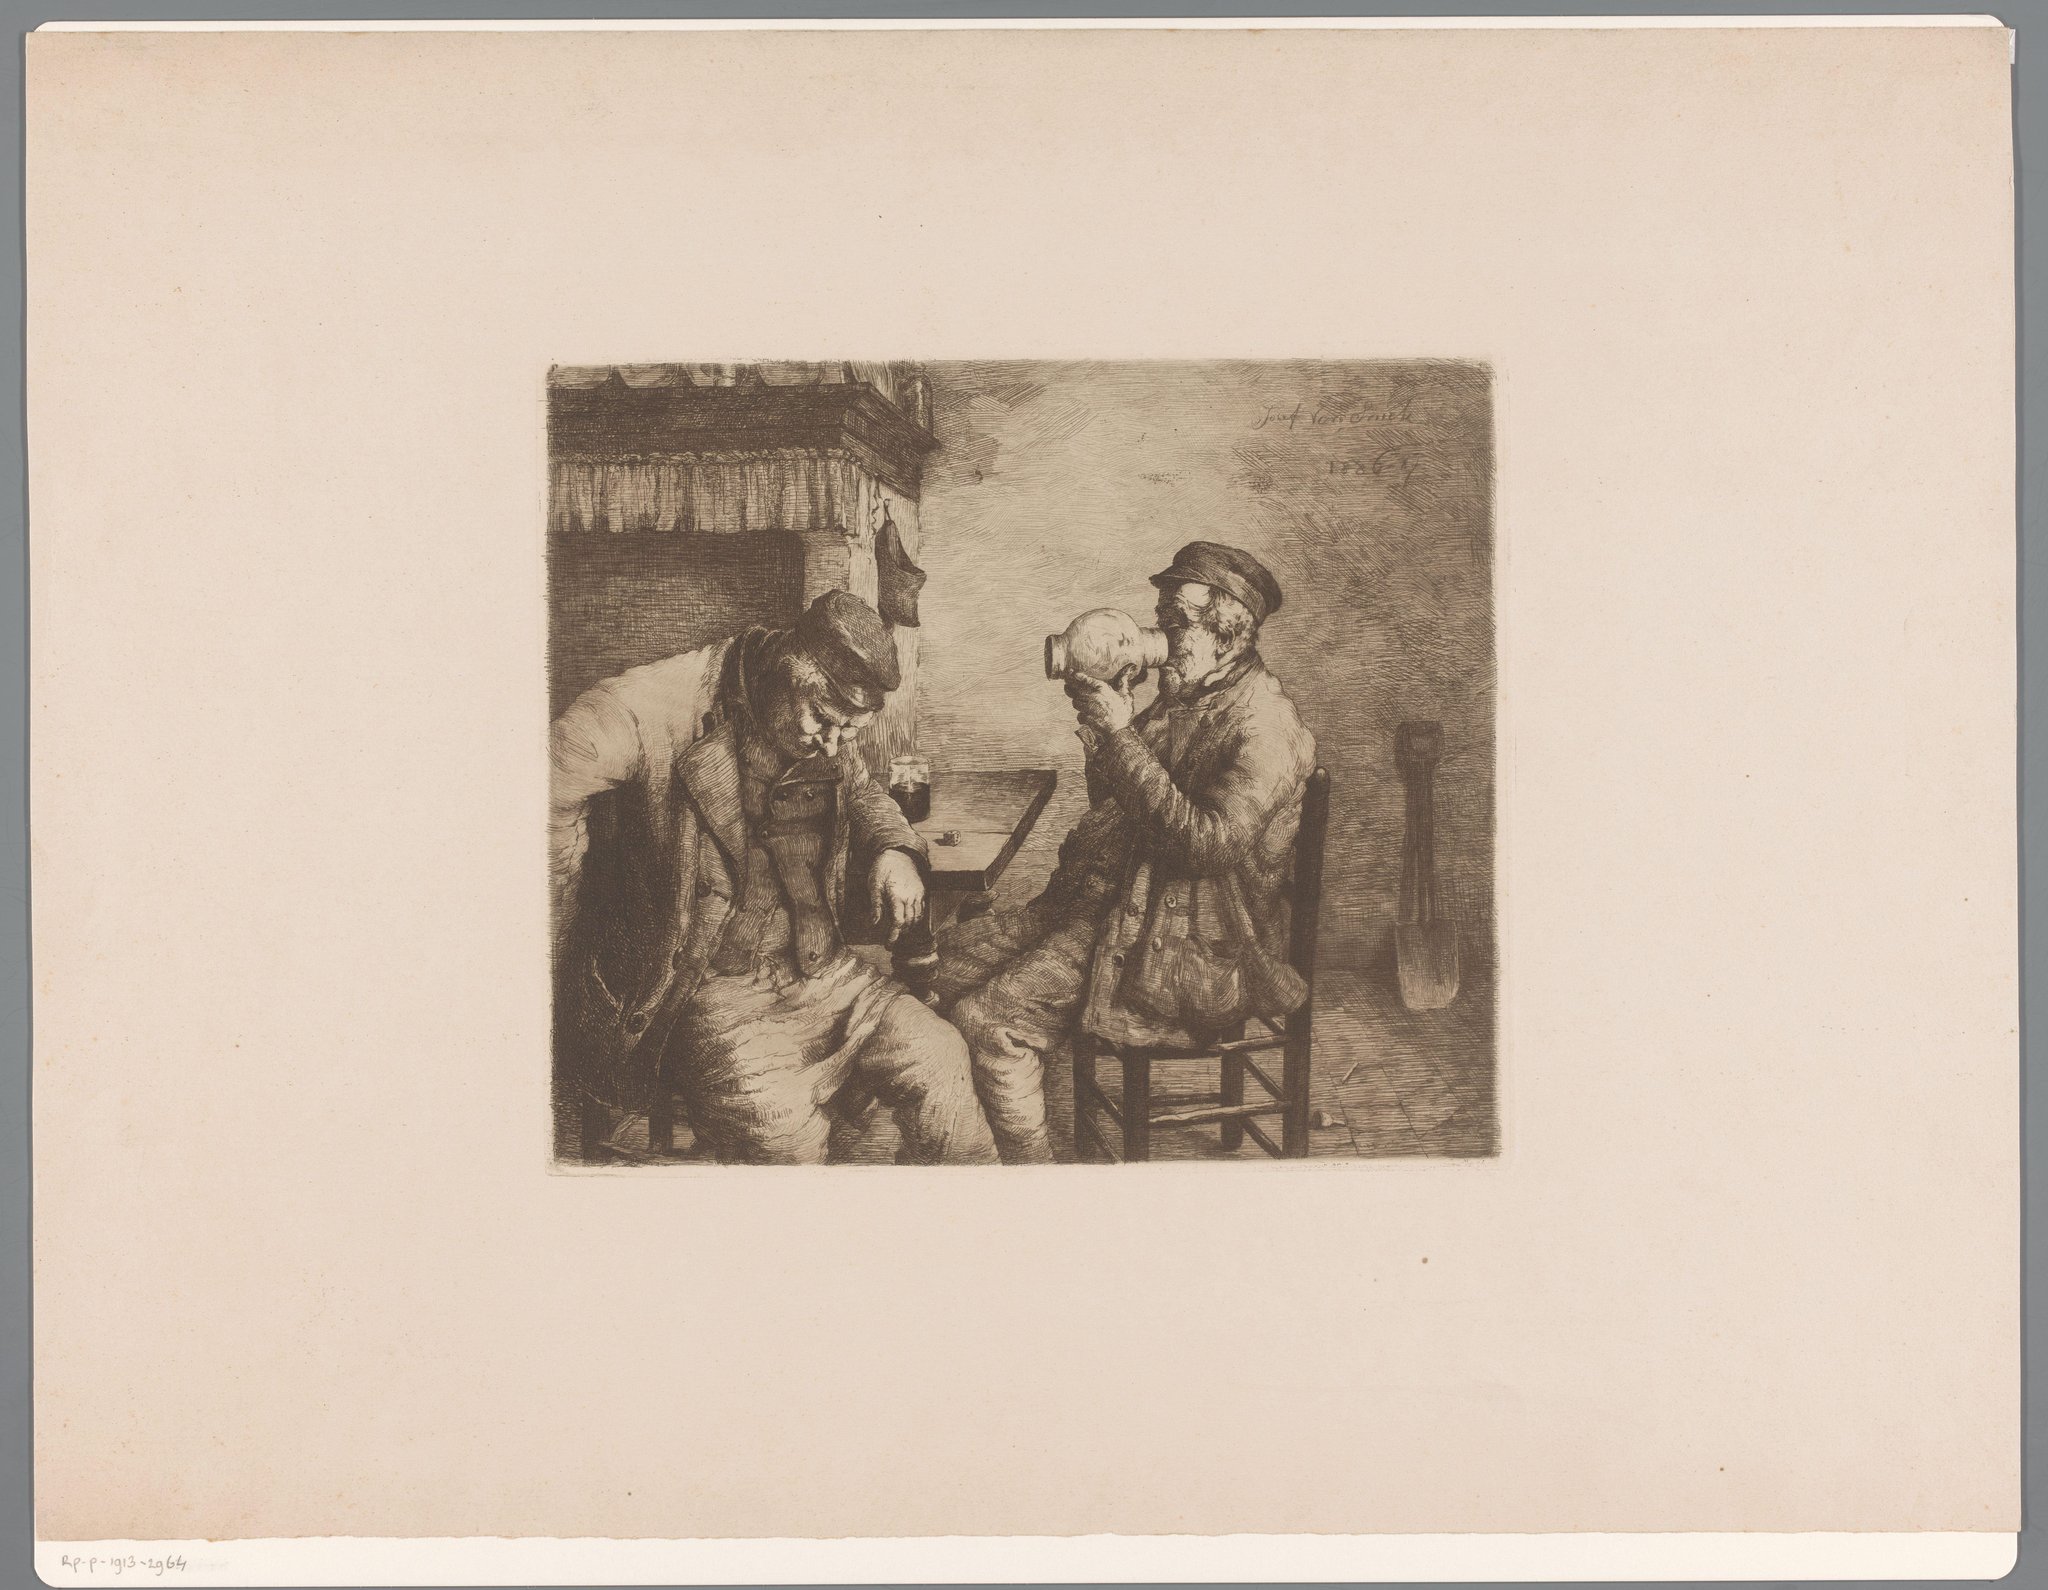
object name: print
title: Twee drinkende mannen aan tafel bij een schouw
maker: jozef van snick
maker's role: print maker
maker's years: 1860-1945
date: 1886-1887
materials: paper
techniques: etching, intaglio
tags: adult man, open hearth, fire-place, dice, drinking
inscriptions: collector's mark: Lugt 2228